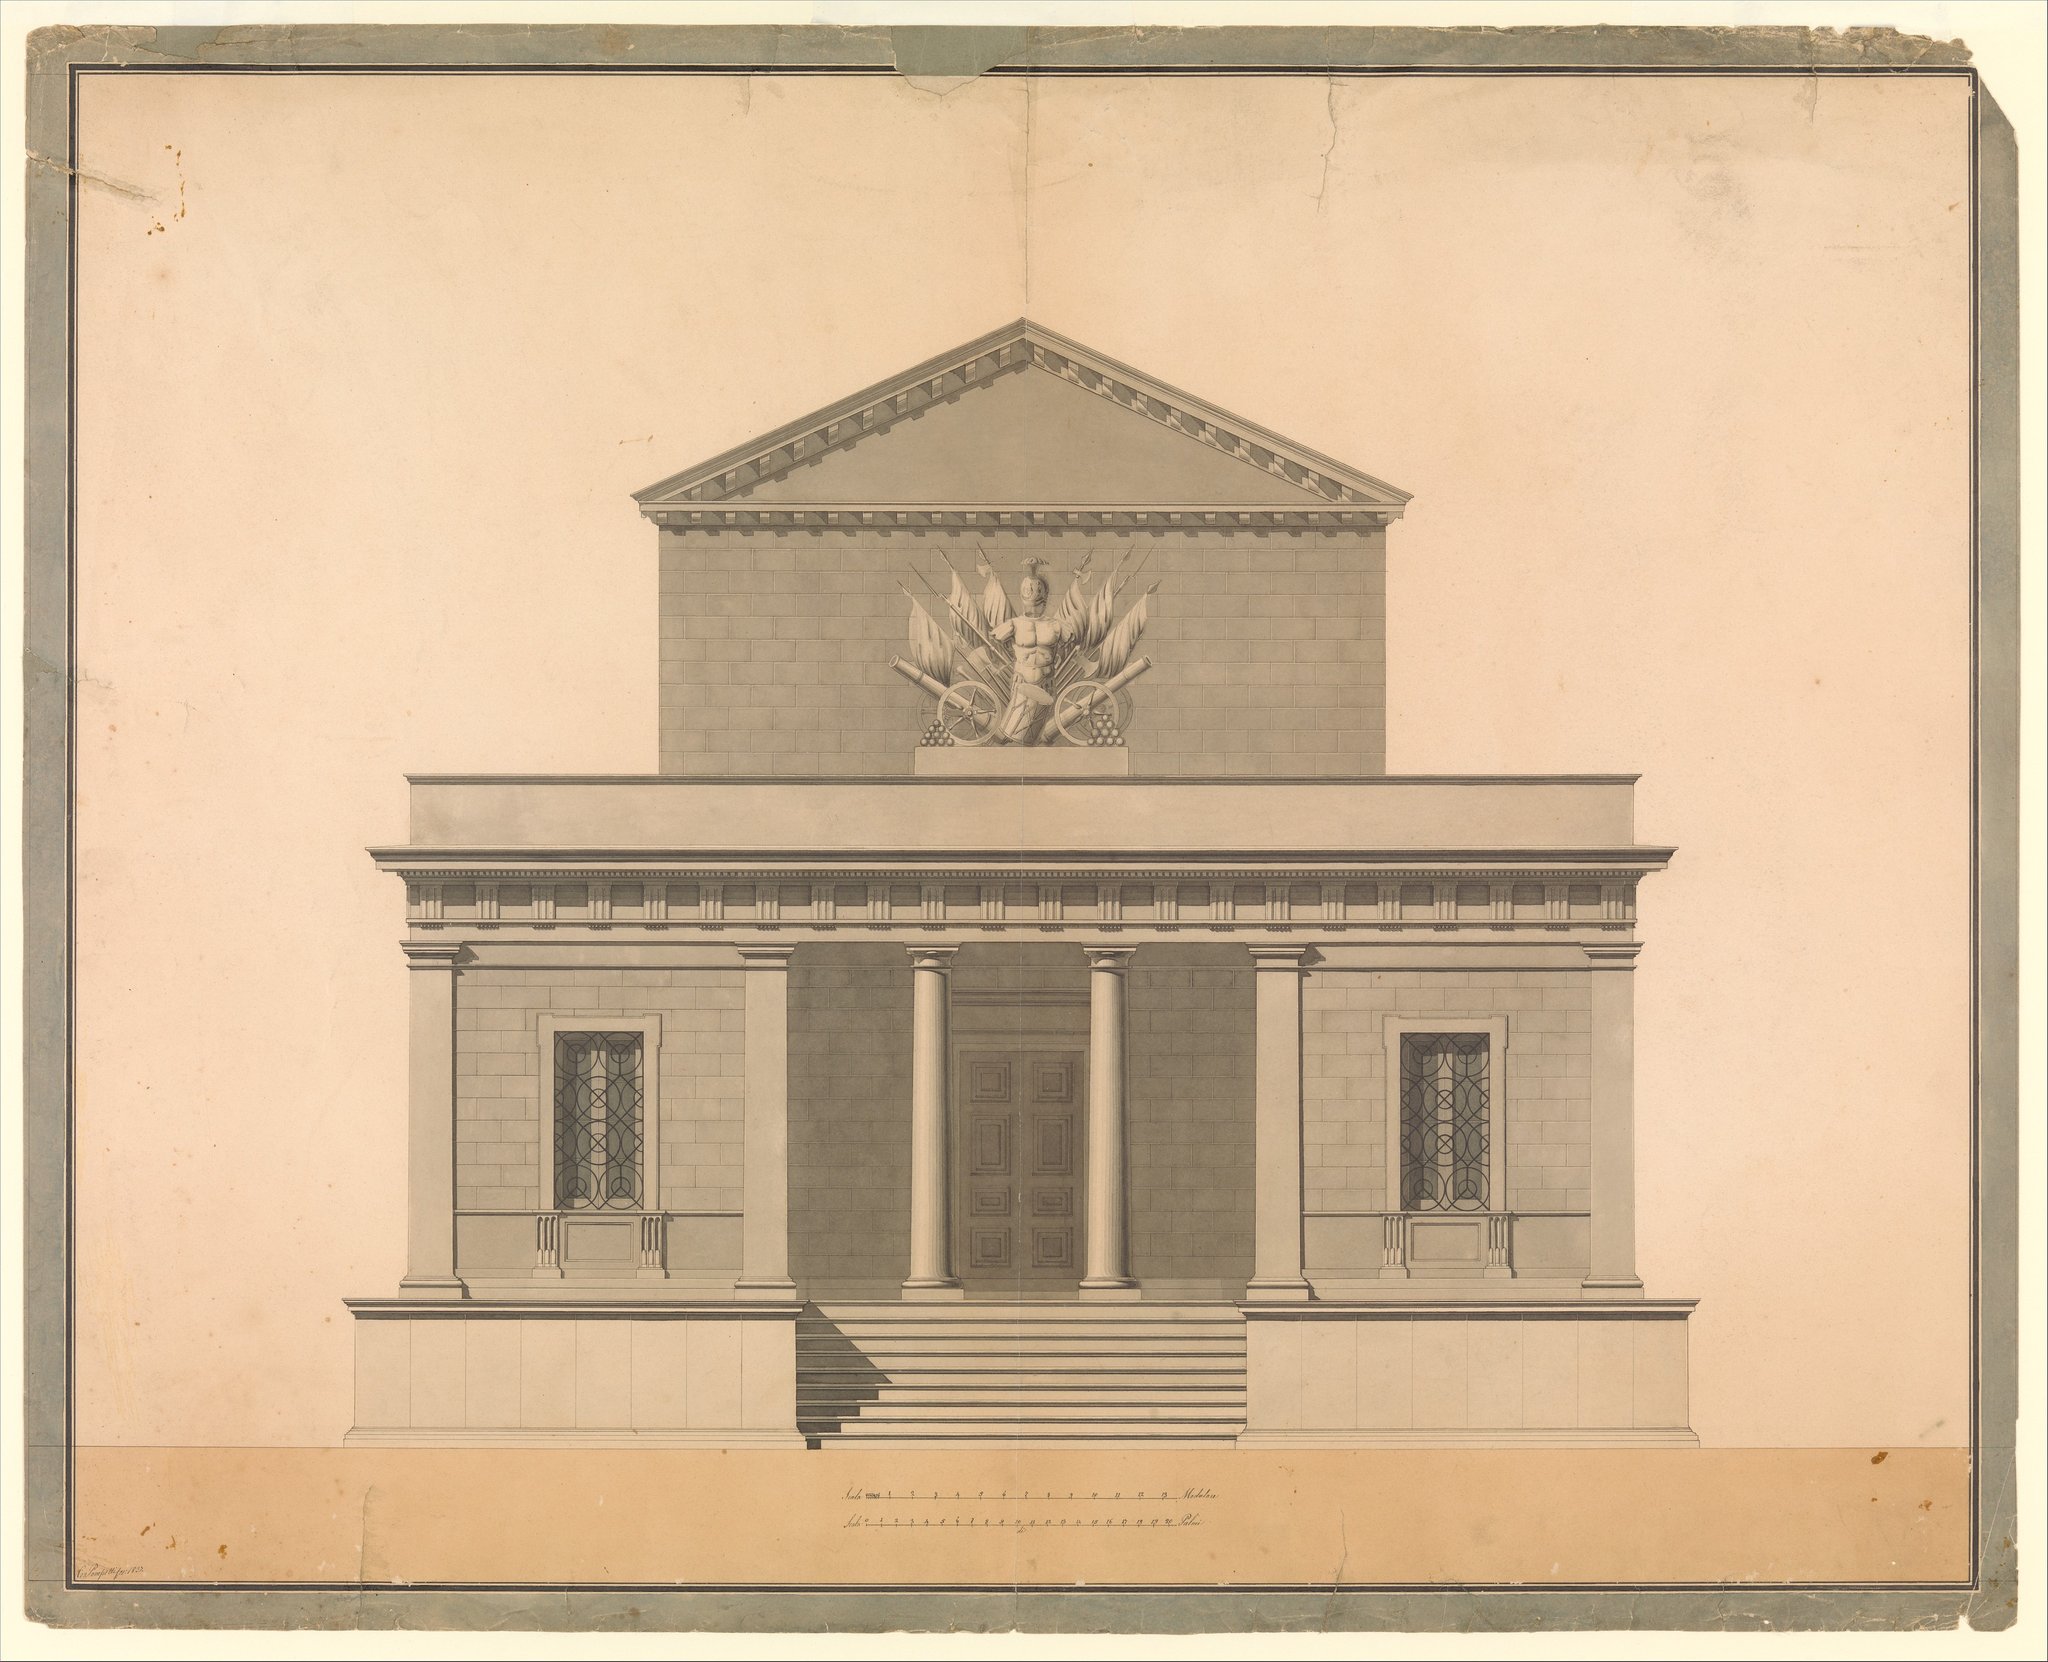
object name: drawing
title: Design for the Façade of an Arsenal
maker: c. pompetti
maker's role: artist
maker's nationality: italian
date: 1837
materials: graphite, ink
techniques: brush, pen, wash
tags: architecture,buildings